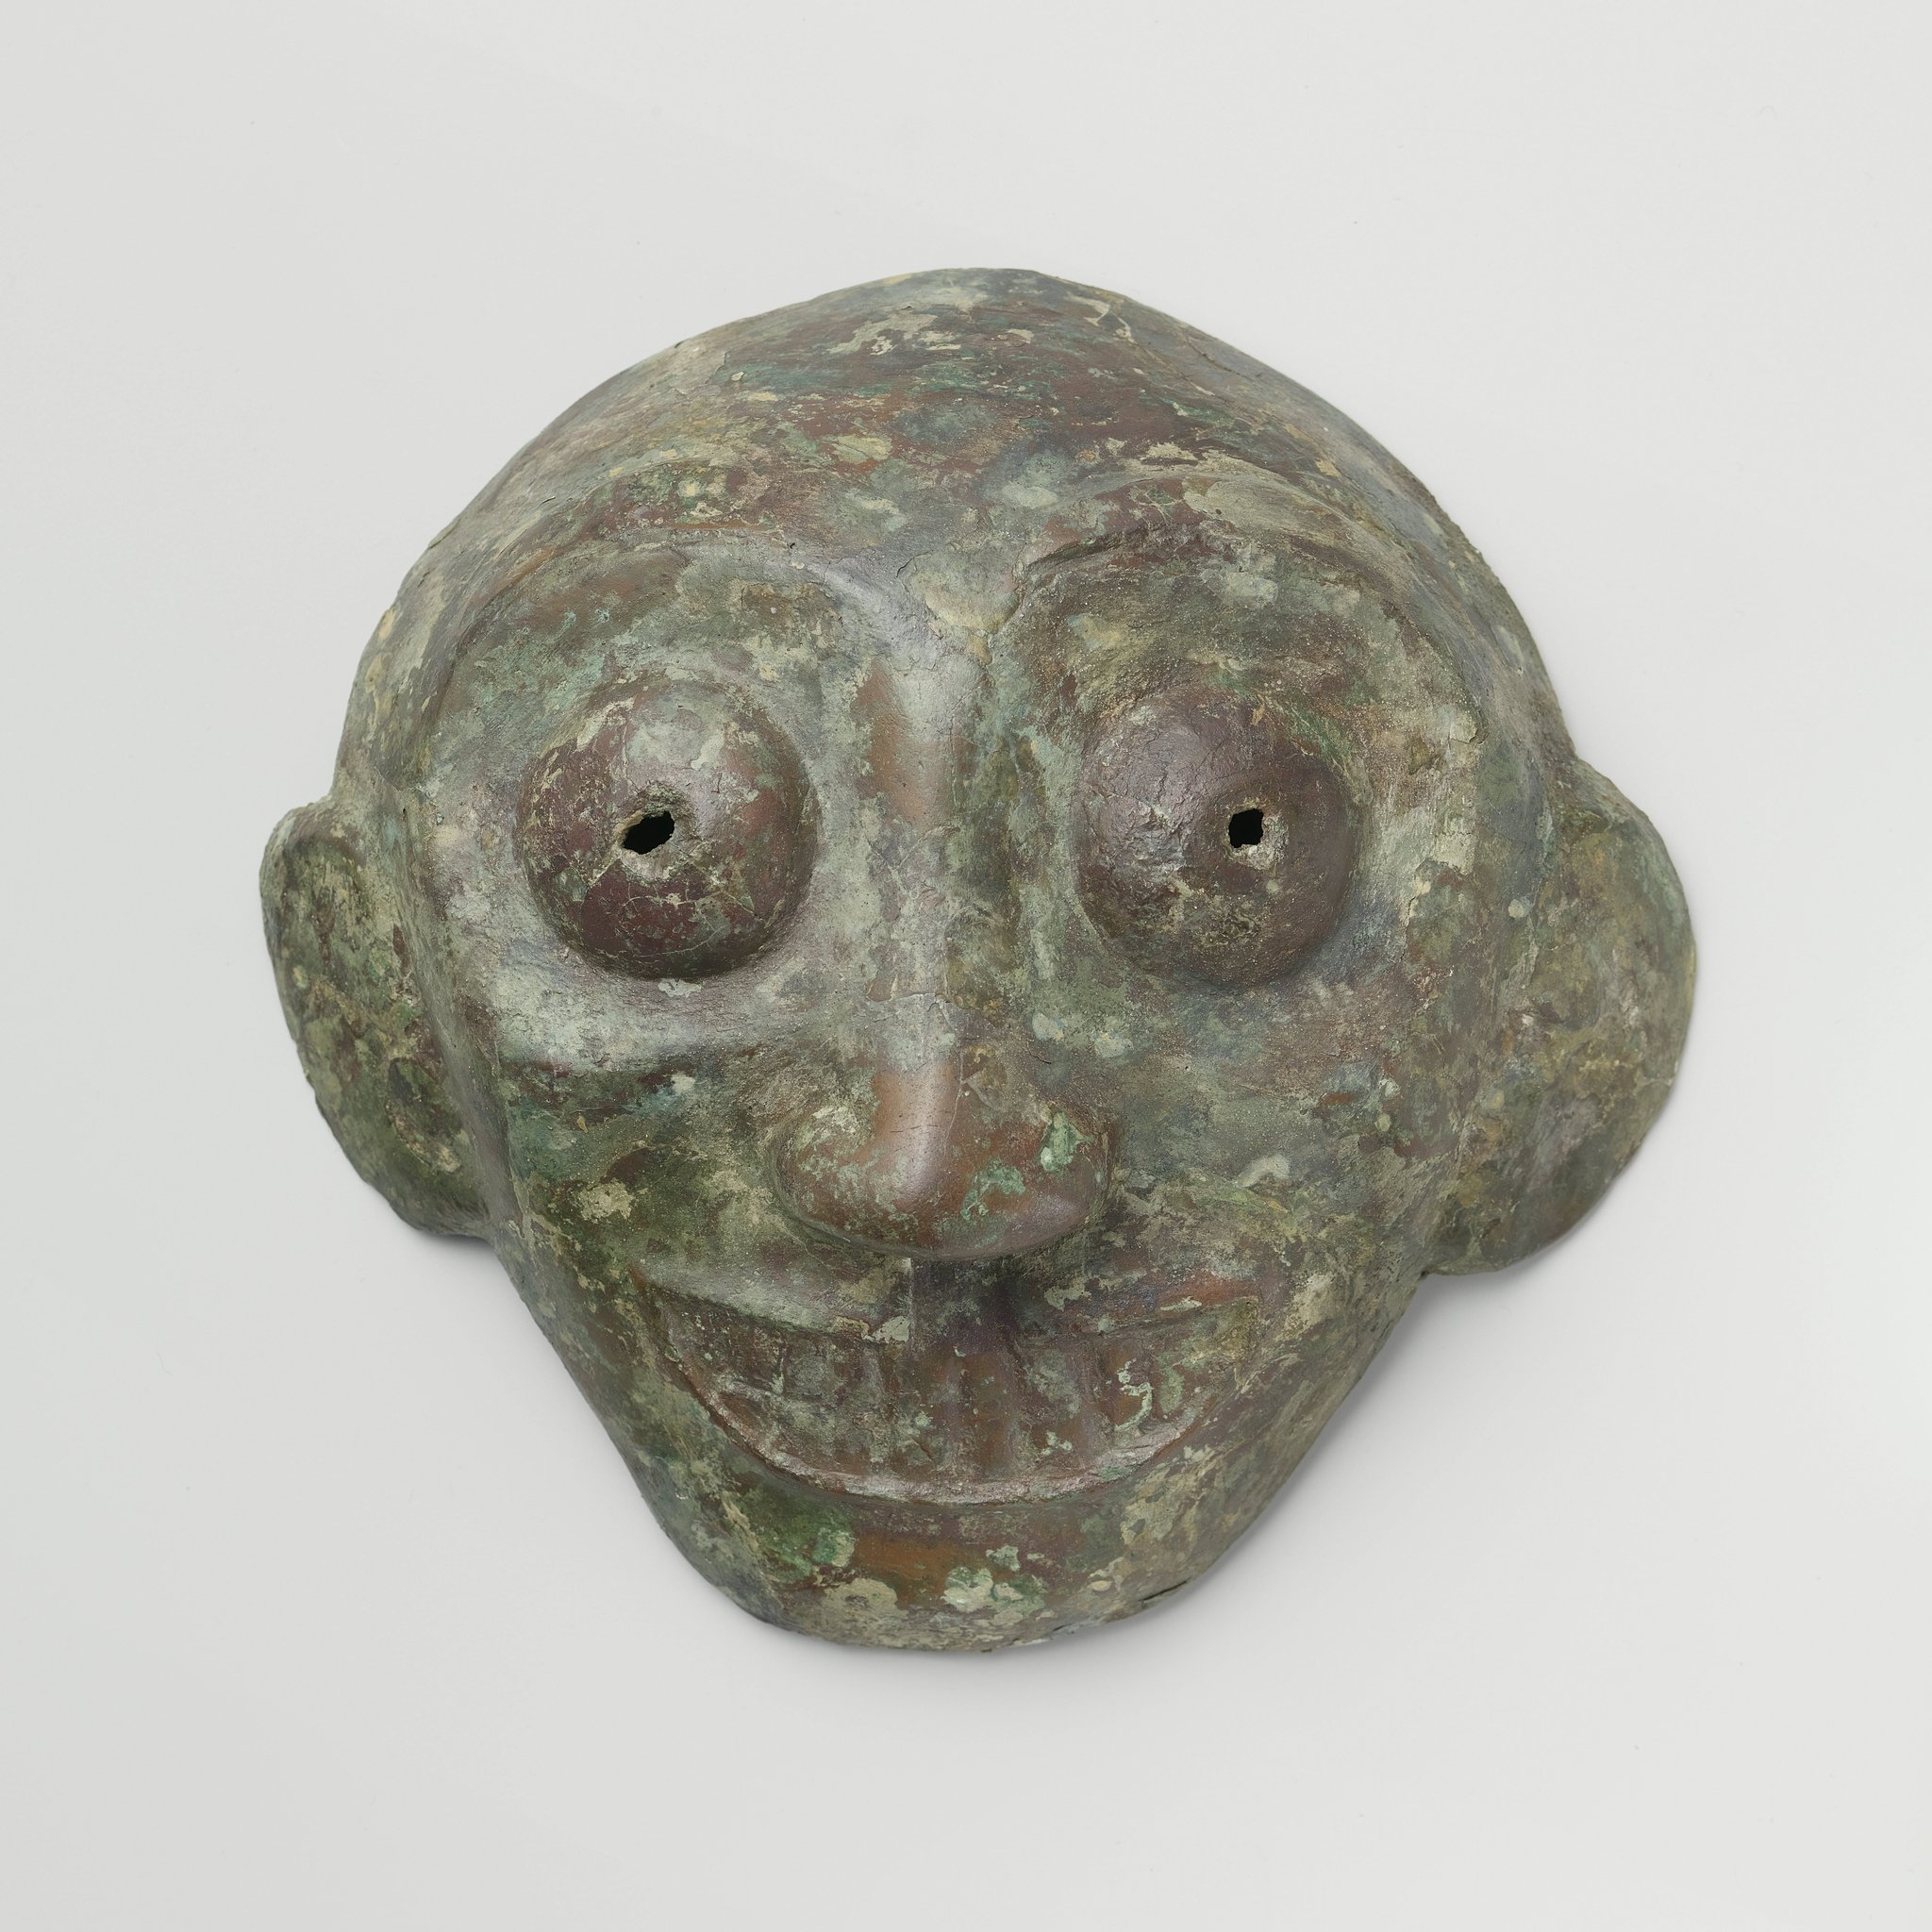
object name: mask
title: Ornament for a shield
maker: Anonymous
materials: bronze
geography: china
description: The human face is only rarely found on ancient Chinese bronzes. This mask features large ears, bulging eyes, a huge nose, and an enormous open mouth clearly revealing teeth. It must have made a terrifying impression and probably served as decoration on a shield to strike fear in the enemy's heart.